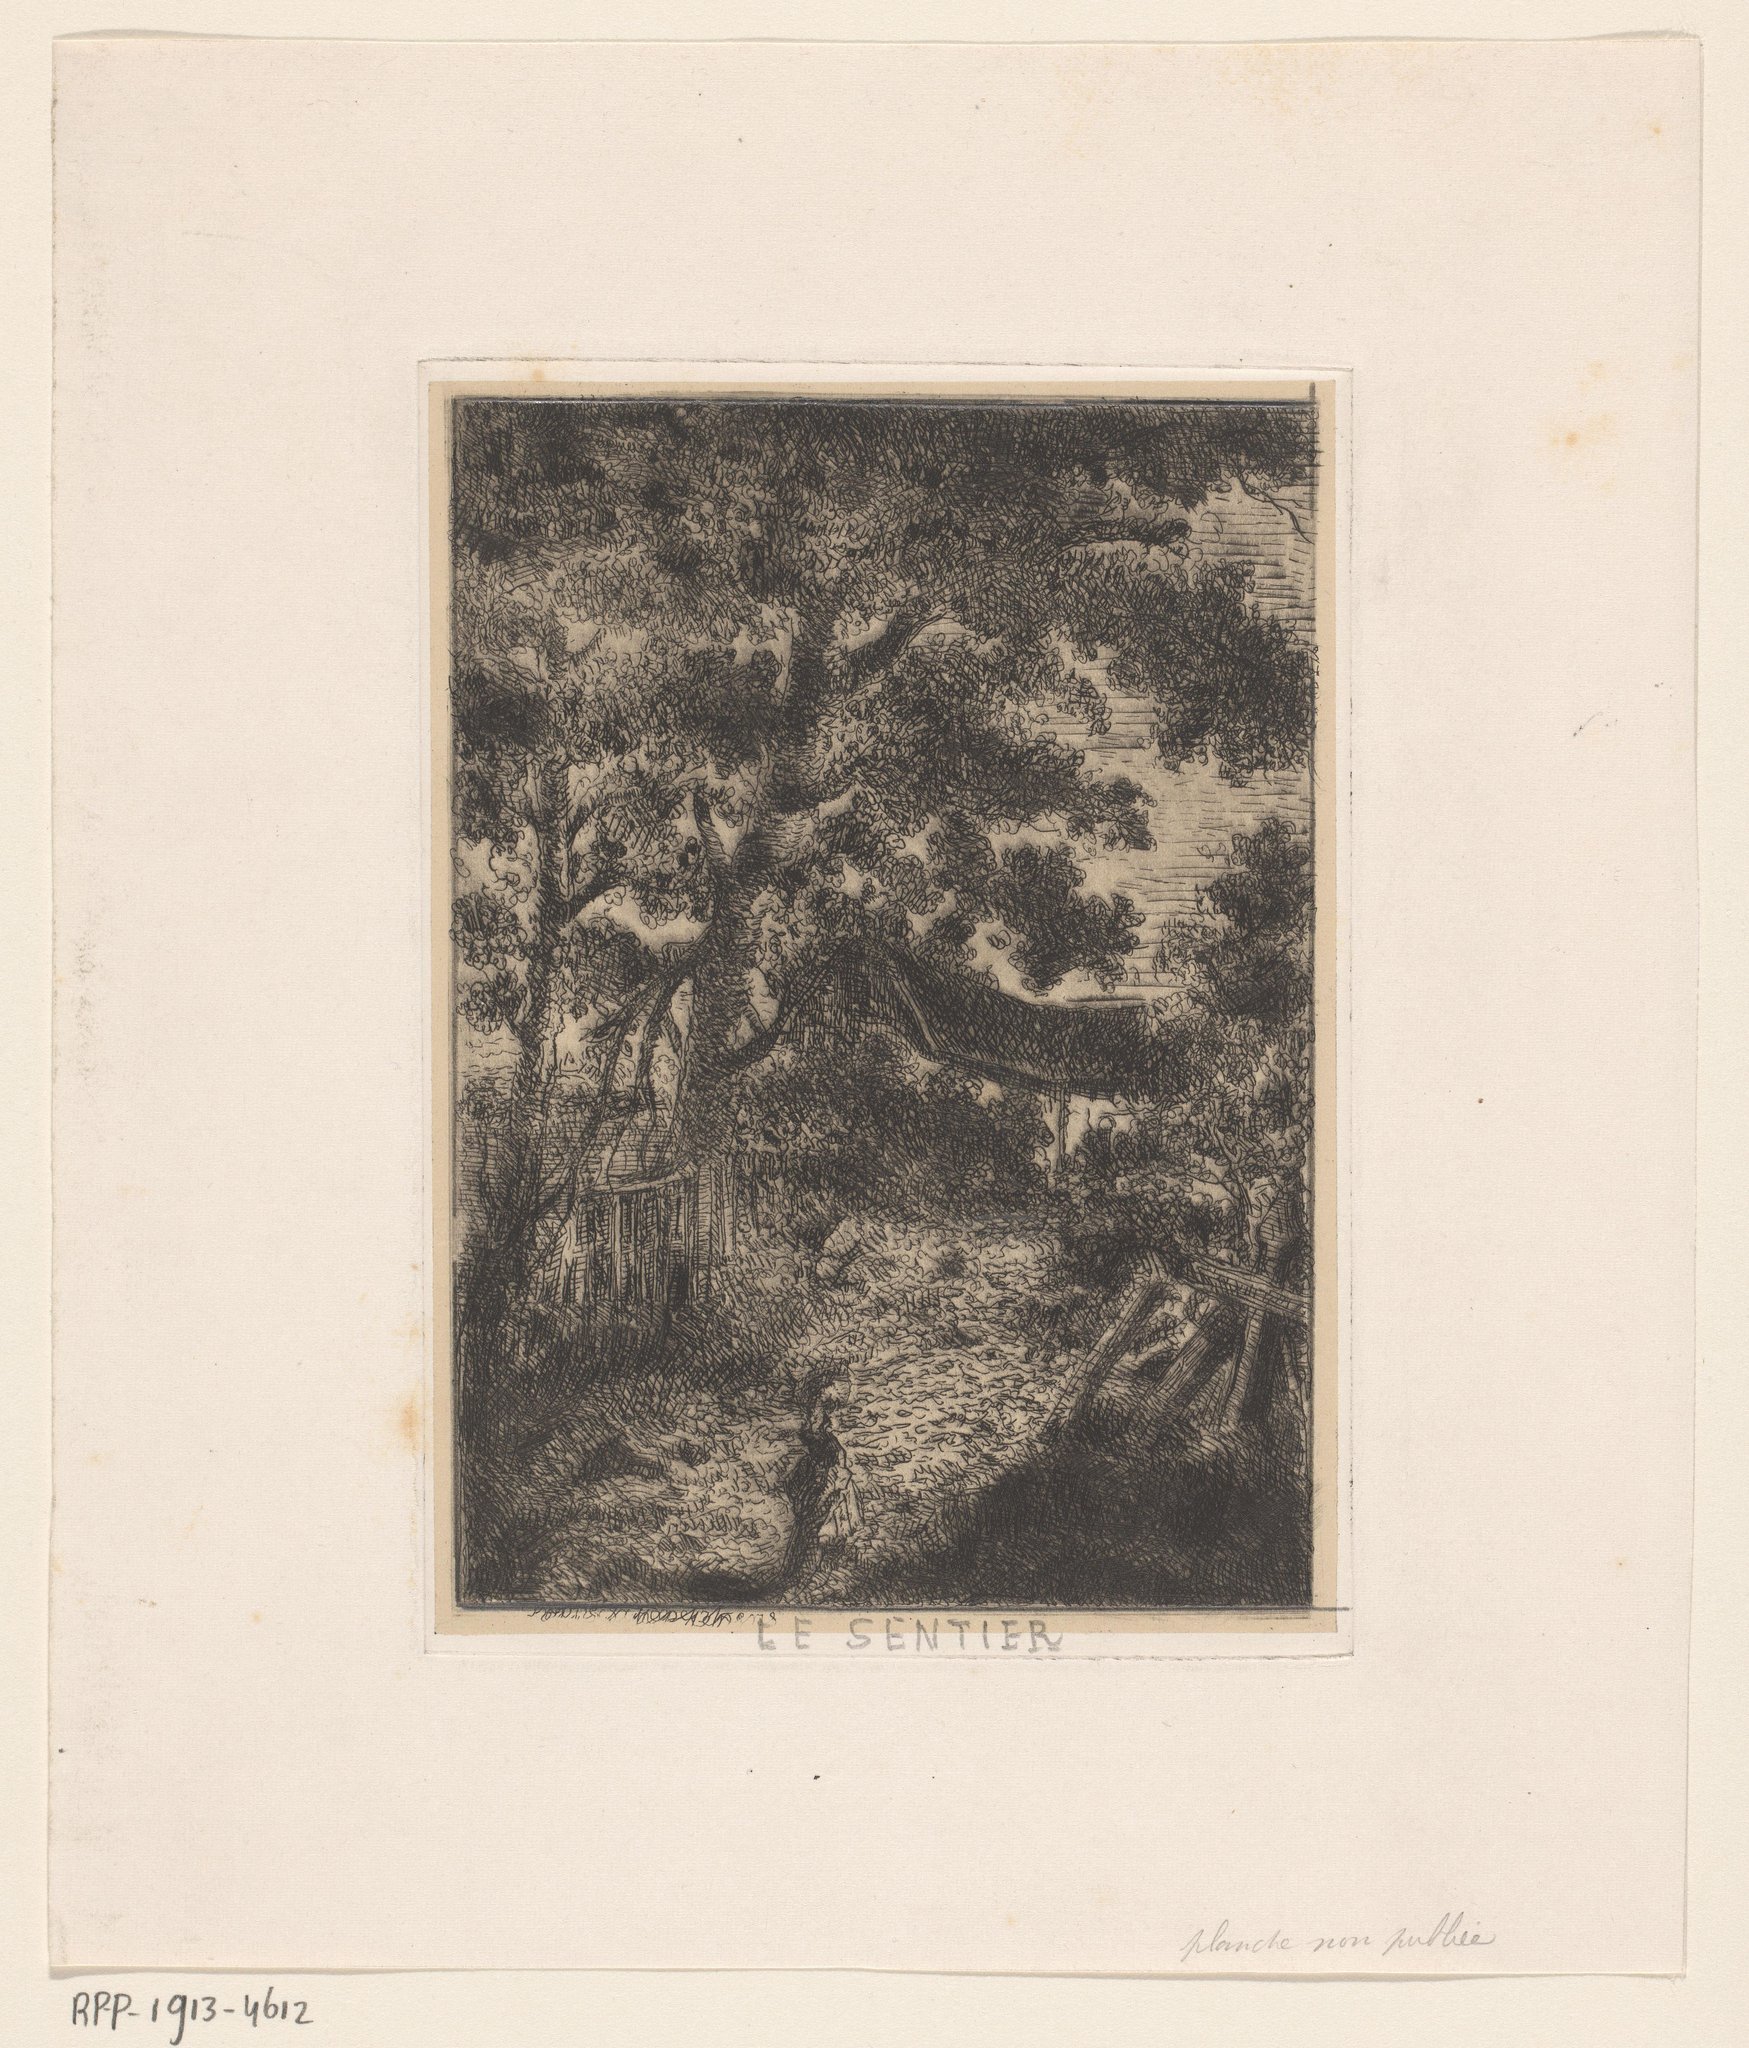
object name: print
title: Vrouw op een bospad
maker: arnoud schaepkens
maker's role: print maker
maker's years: 1816-1904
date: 1831-1904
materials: paper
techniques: drypoint, etching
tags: forest path or lane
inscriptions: collector's mark: Lugt 2228